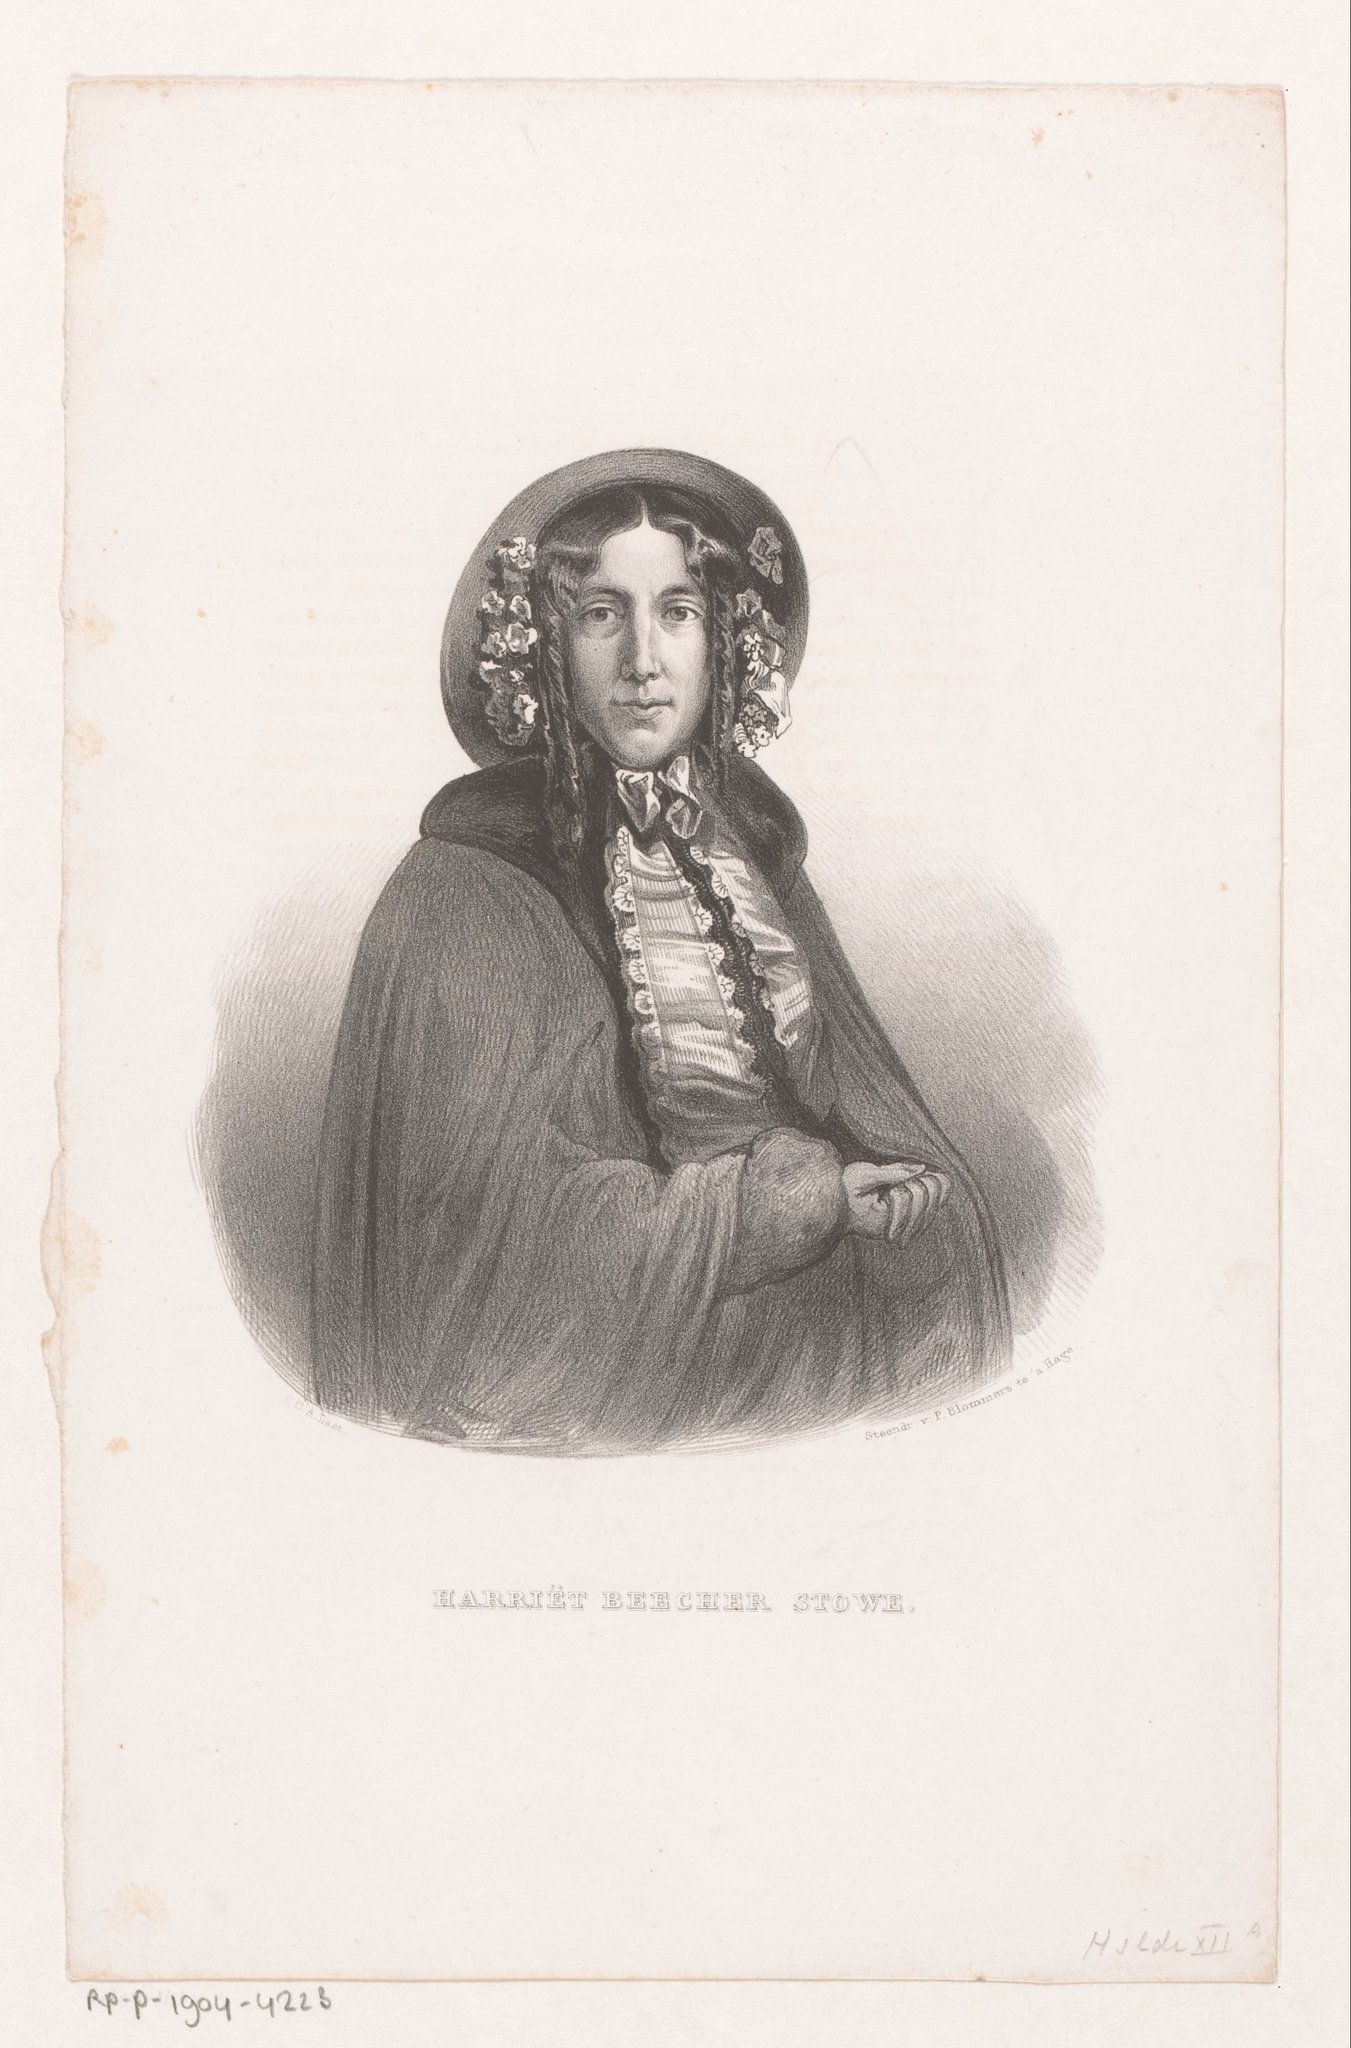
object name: print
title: Portret van Harriët Beecher Stowe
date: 1842-1876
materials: paper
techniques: lithograph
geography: the hague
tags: head-gear: hat, historical persons (+ (full) bust portrait)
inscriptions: collector's mark: Lugt 2228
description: De geportretteerde draagt een mantel, een hoed en bloemen in het haar. Onder het portret haar naam.